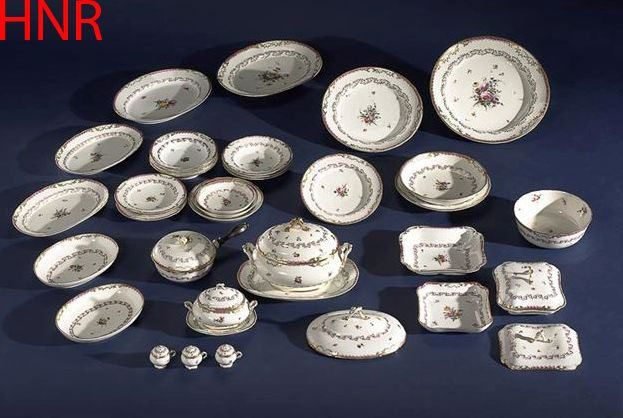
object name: plate dish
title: Bord, diep model, behorend bij een servies met geslingerd lintmotief met bladertakken, bloemboeketten en gestrooide bloemtakken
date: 1780-1820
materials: porcelain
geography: loosdrecht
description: Bord, diep model, behorend bij een servies van porselein met geslingerd lintmotief in paars en goud met groene bladertakken, bloemboeketten en gestrooide bloemtakken. Randen lichtgegolfd met decoratie in goud met paars bladmotief waartussen groen gekruist bladmotief. Gemerkt: M.O.L. en Amstel. Serie van vijftien stuks.